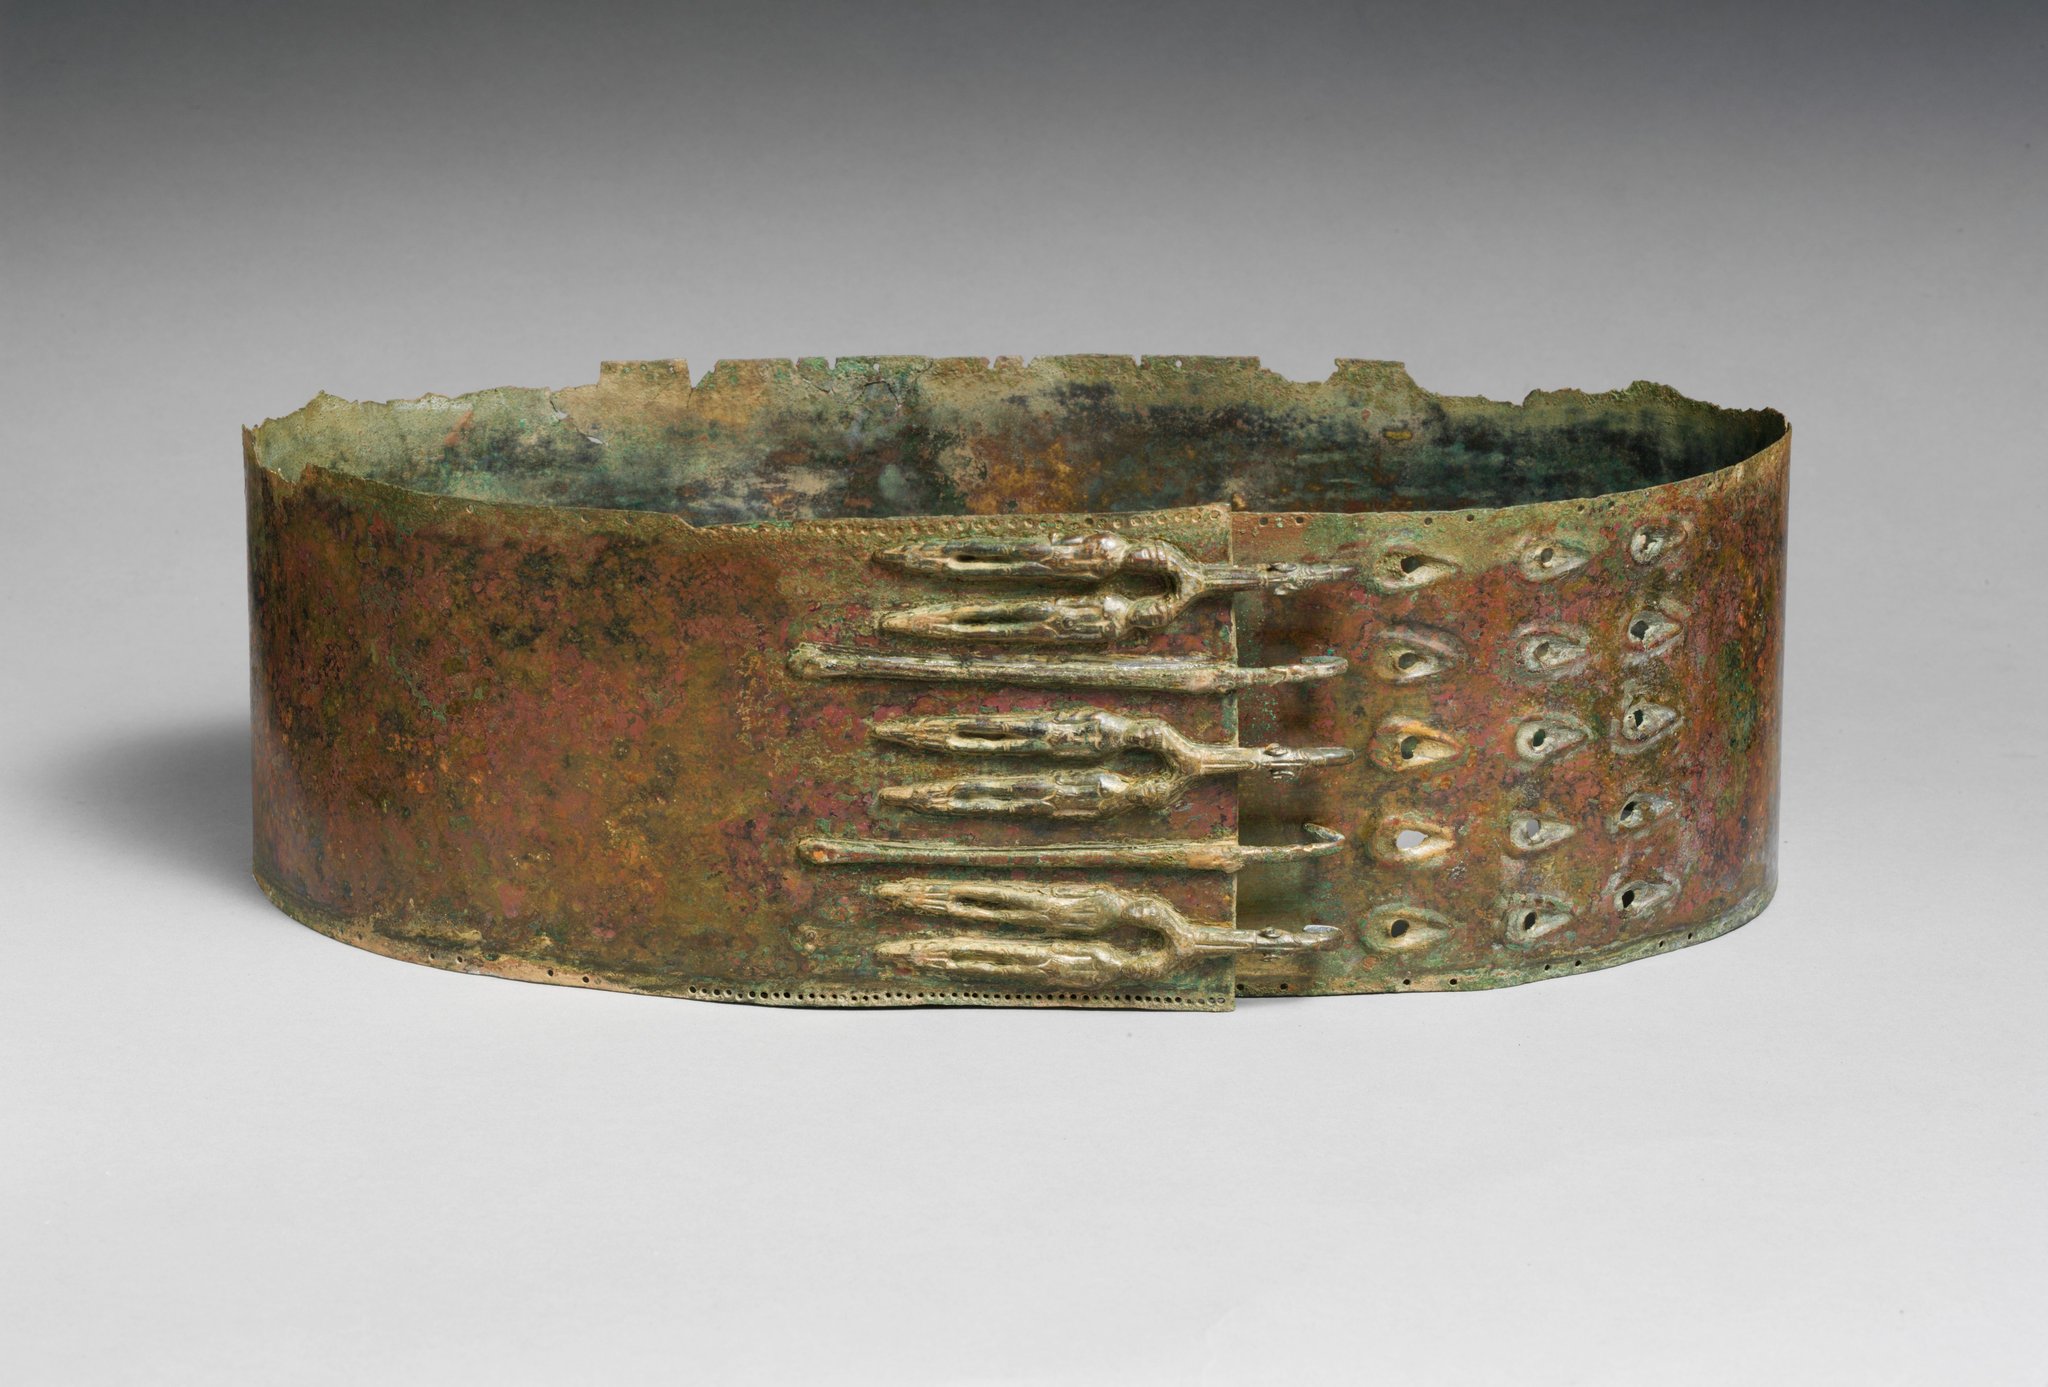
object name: belt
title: Bronze belt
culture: italic, samnite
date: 350-325 BCE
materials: bronze